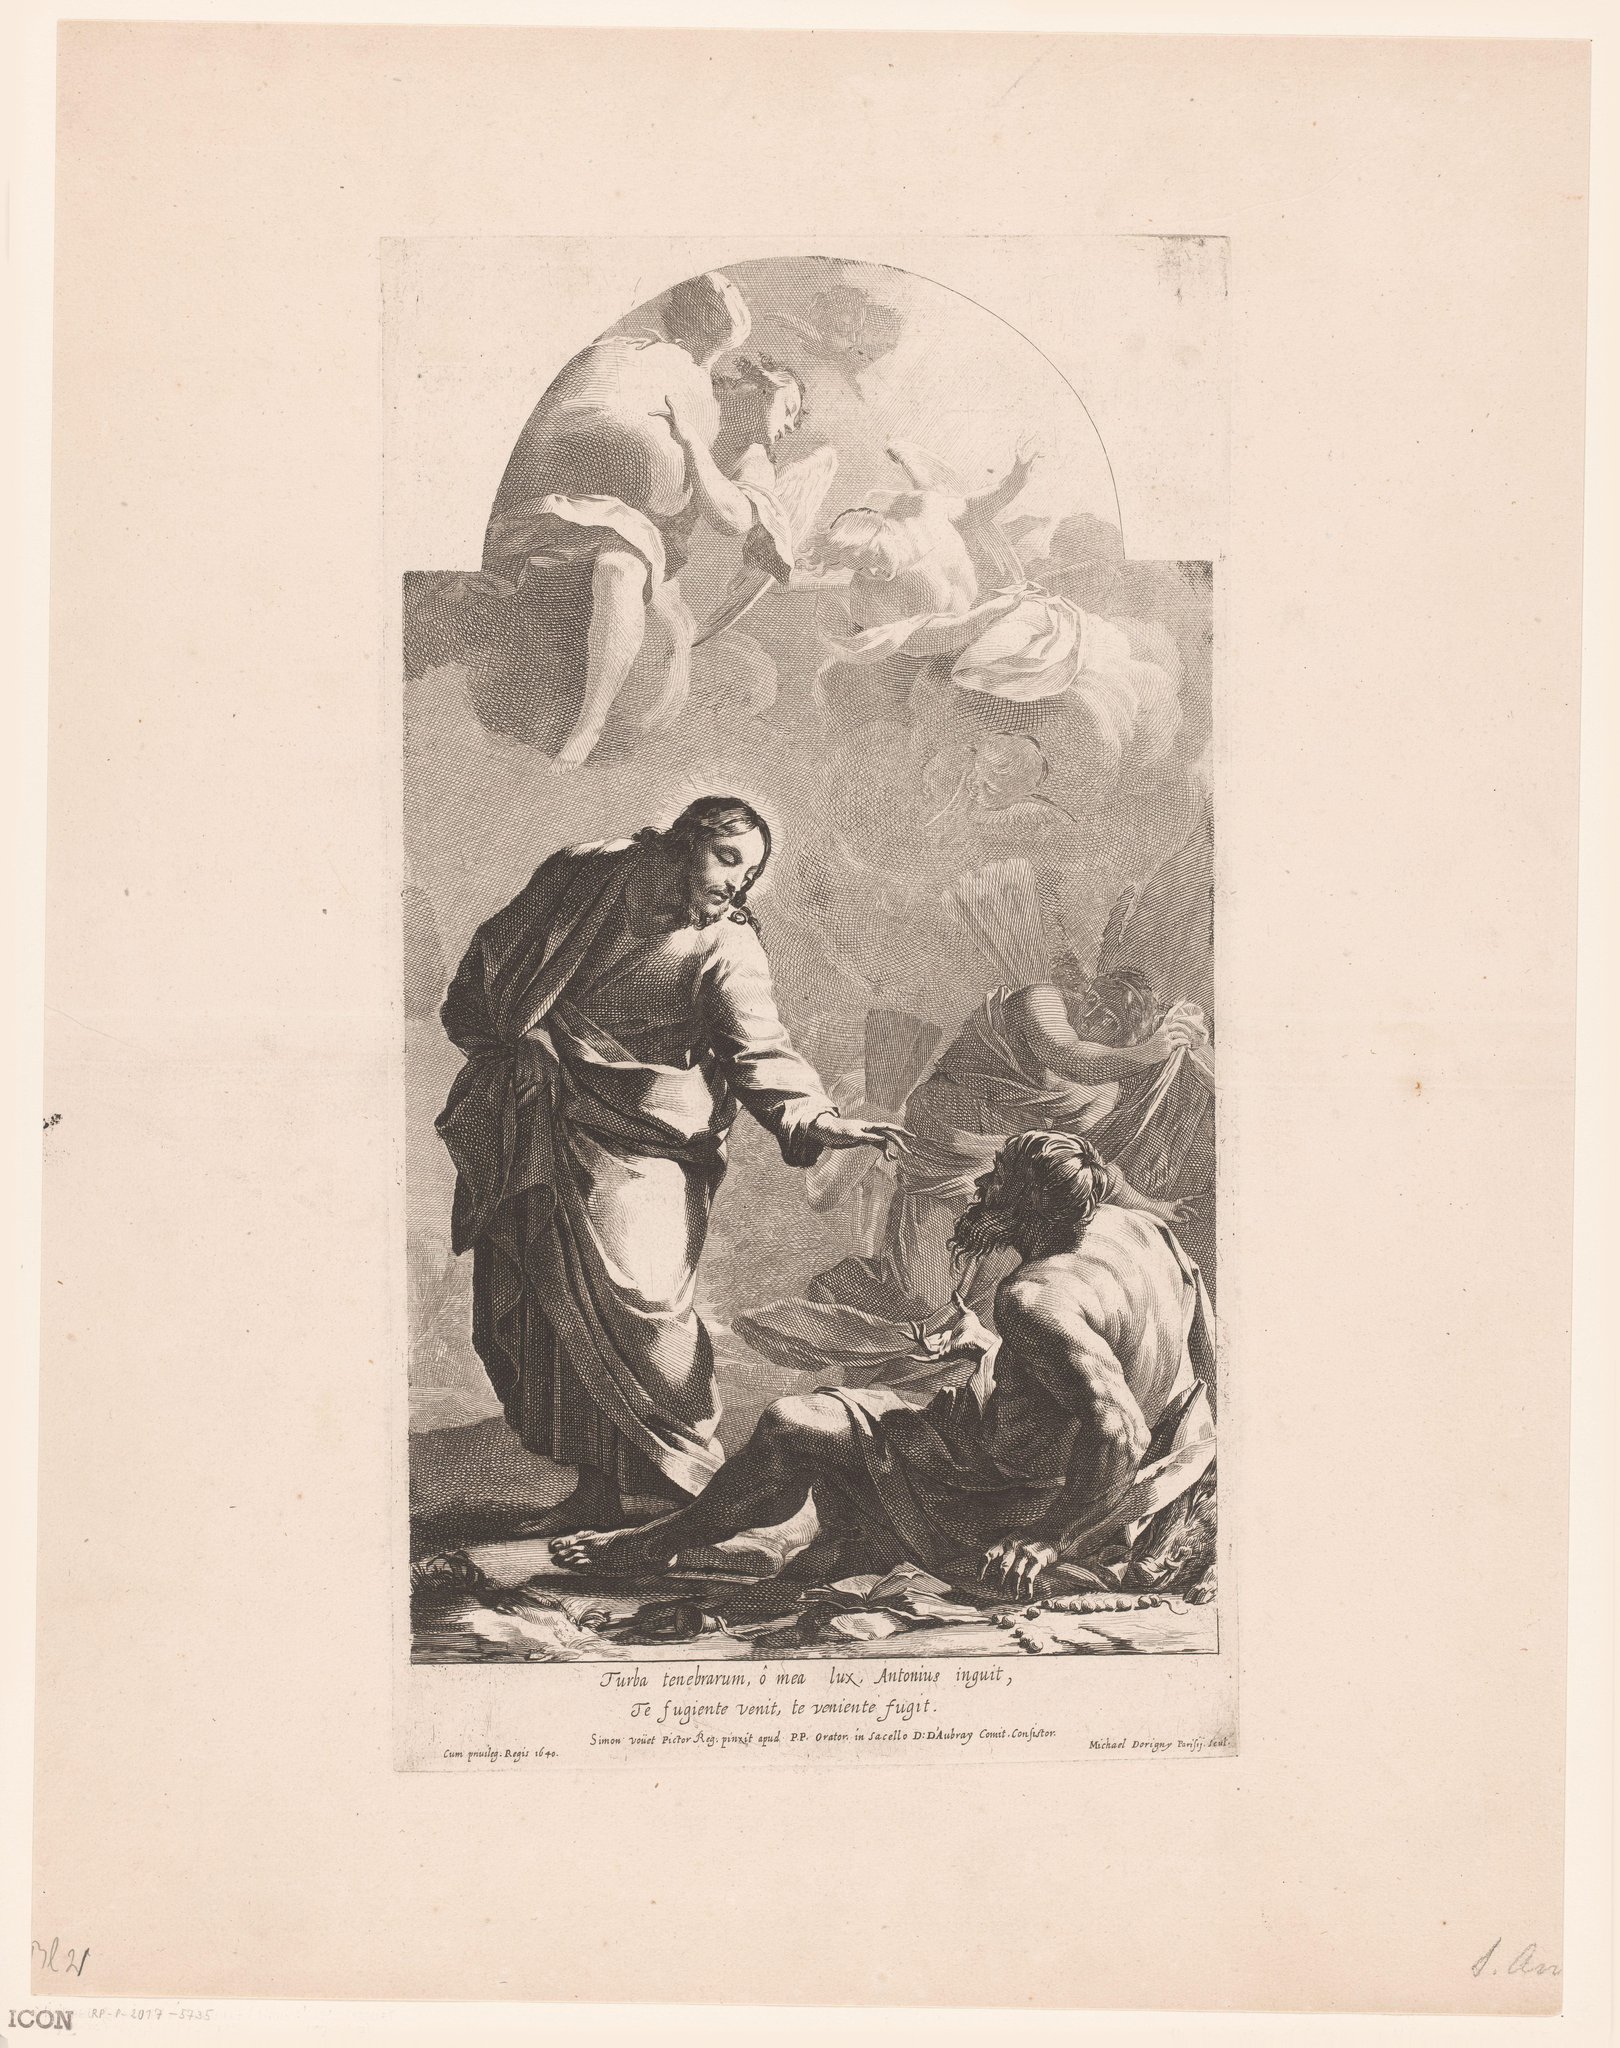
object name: print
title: Christus en H. Antonius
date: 1640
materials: paper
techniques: engraving, etching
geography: france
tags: temptations of st. antony abbot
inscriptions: collector's mark: Lugt 2228